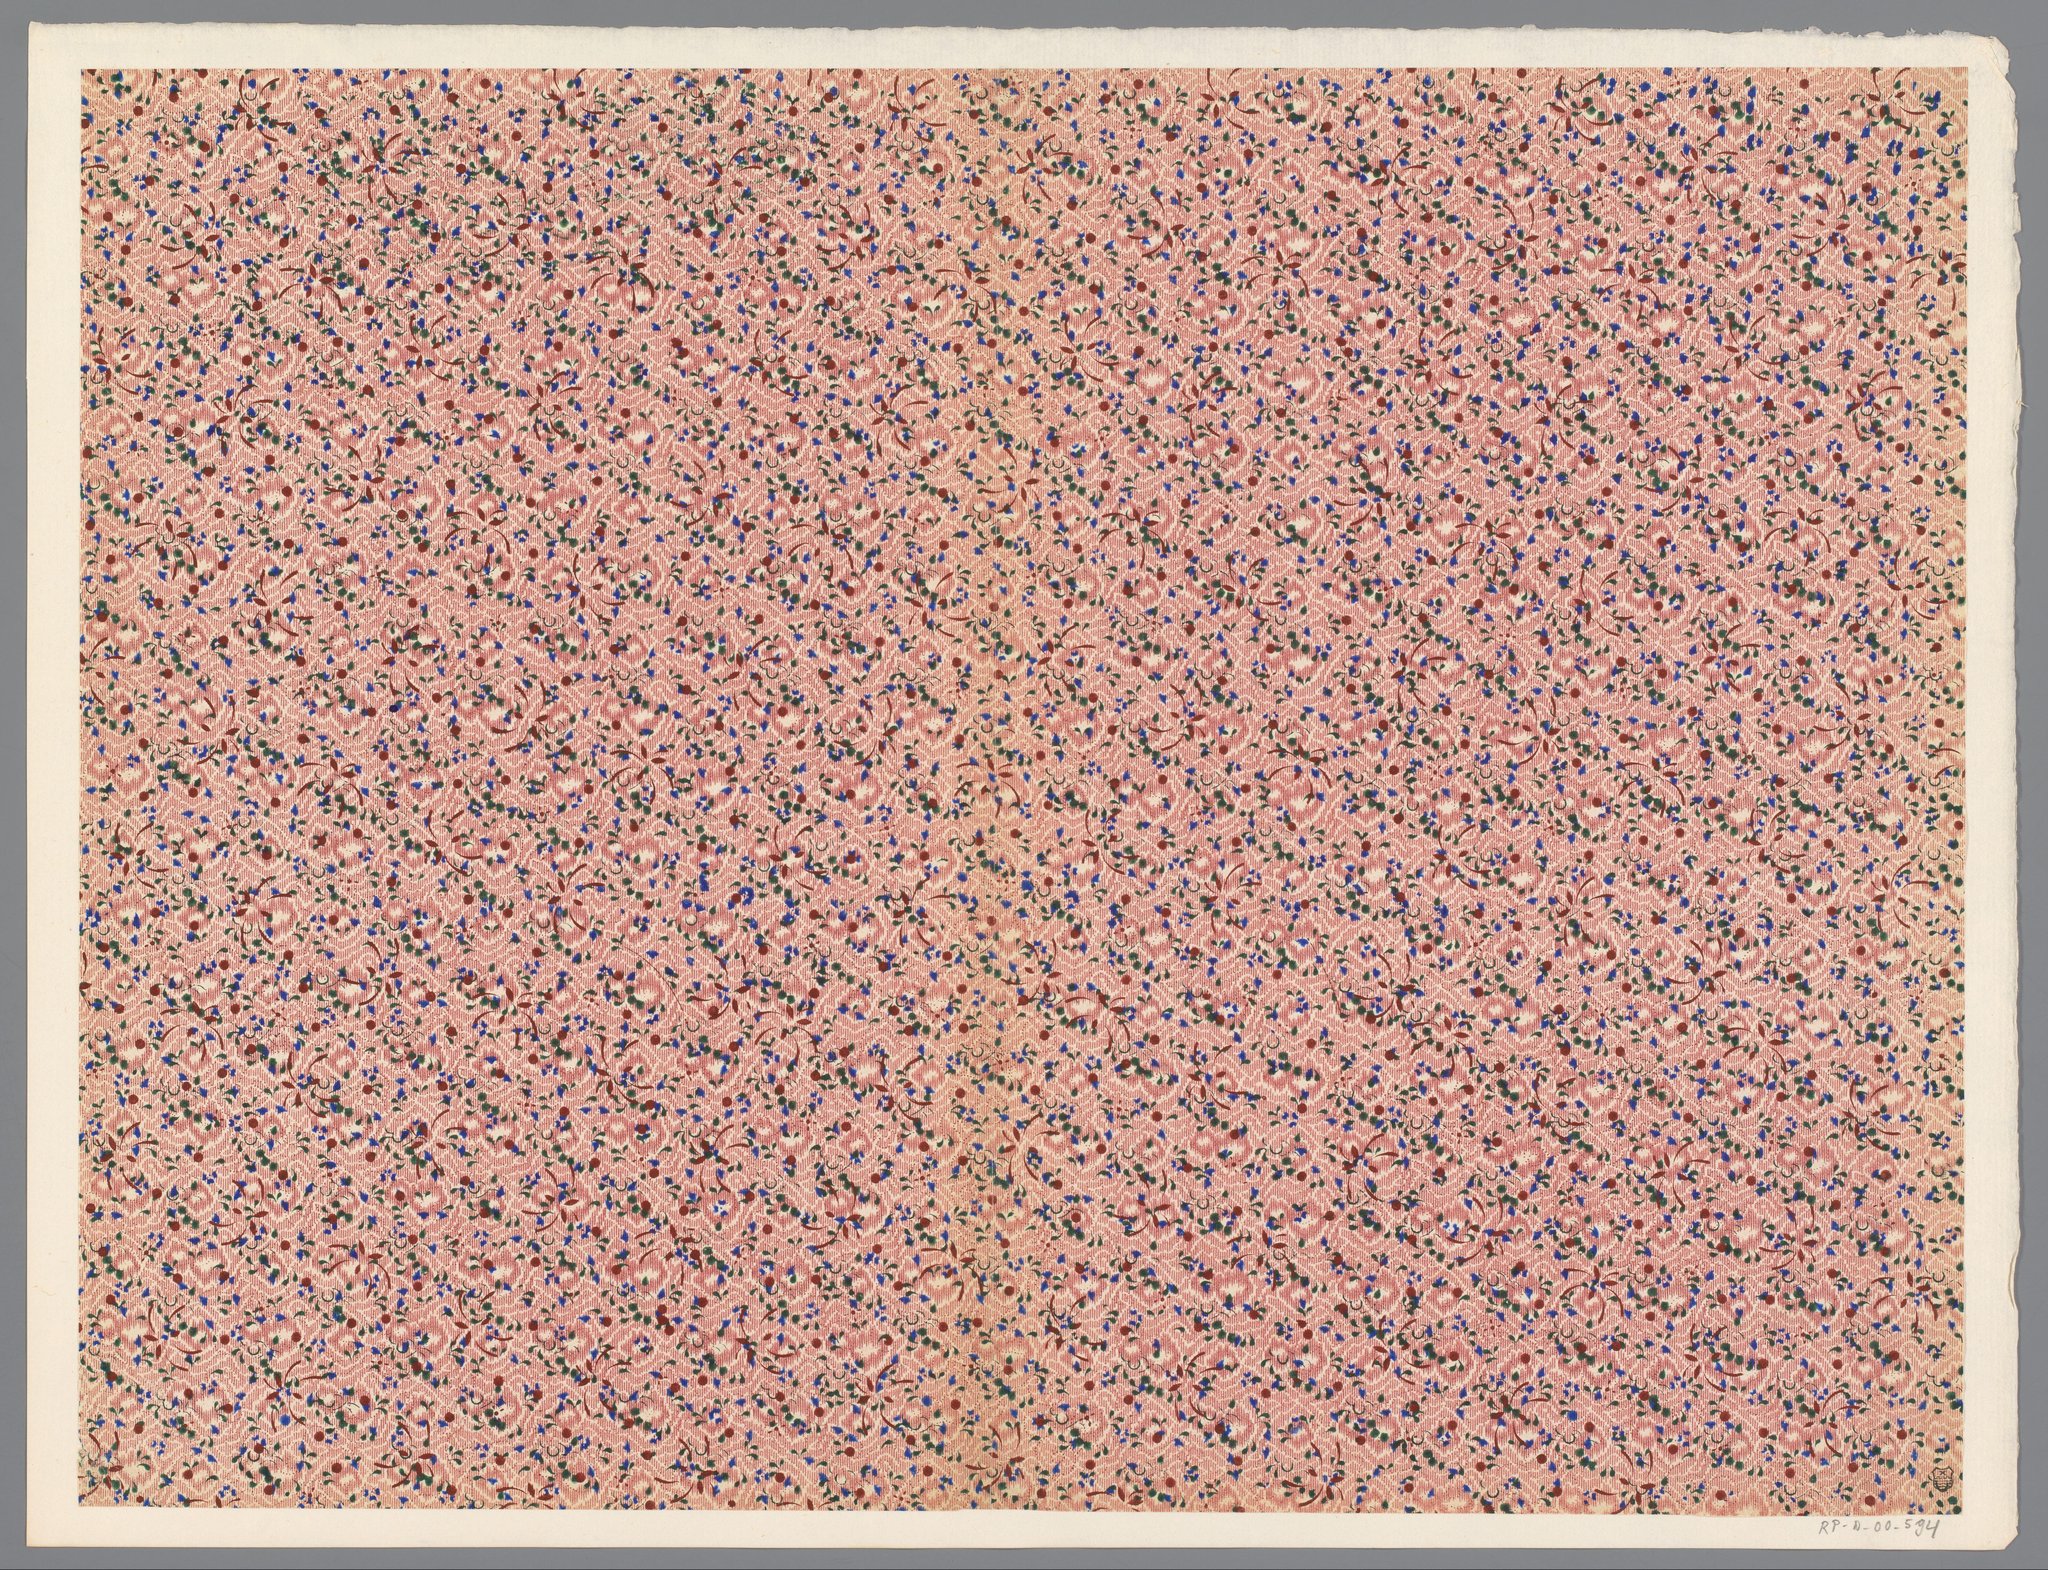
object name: printed paper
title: Blad met strooipatroon van bloemmotief op onderbroken lijnenfond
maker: Anonymous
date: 1800-1900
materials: paper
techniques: printing block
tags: ornament derived from plant forms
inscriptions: collector's mark: Lugt 2760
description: Blad met strooipatroon van bloemmotief op onderbroken diagonaal lijnenfond.